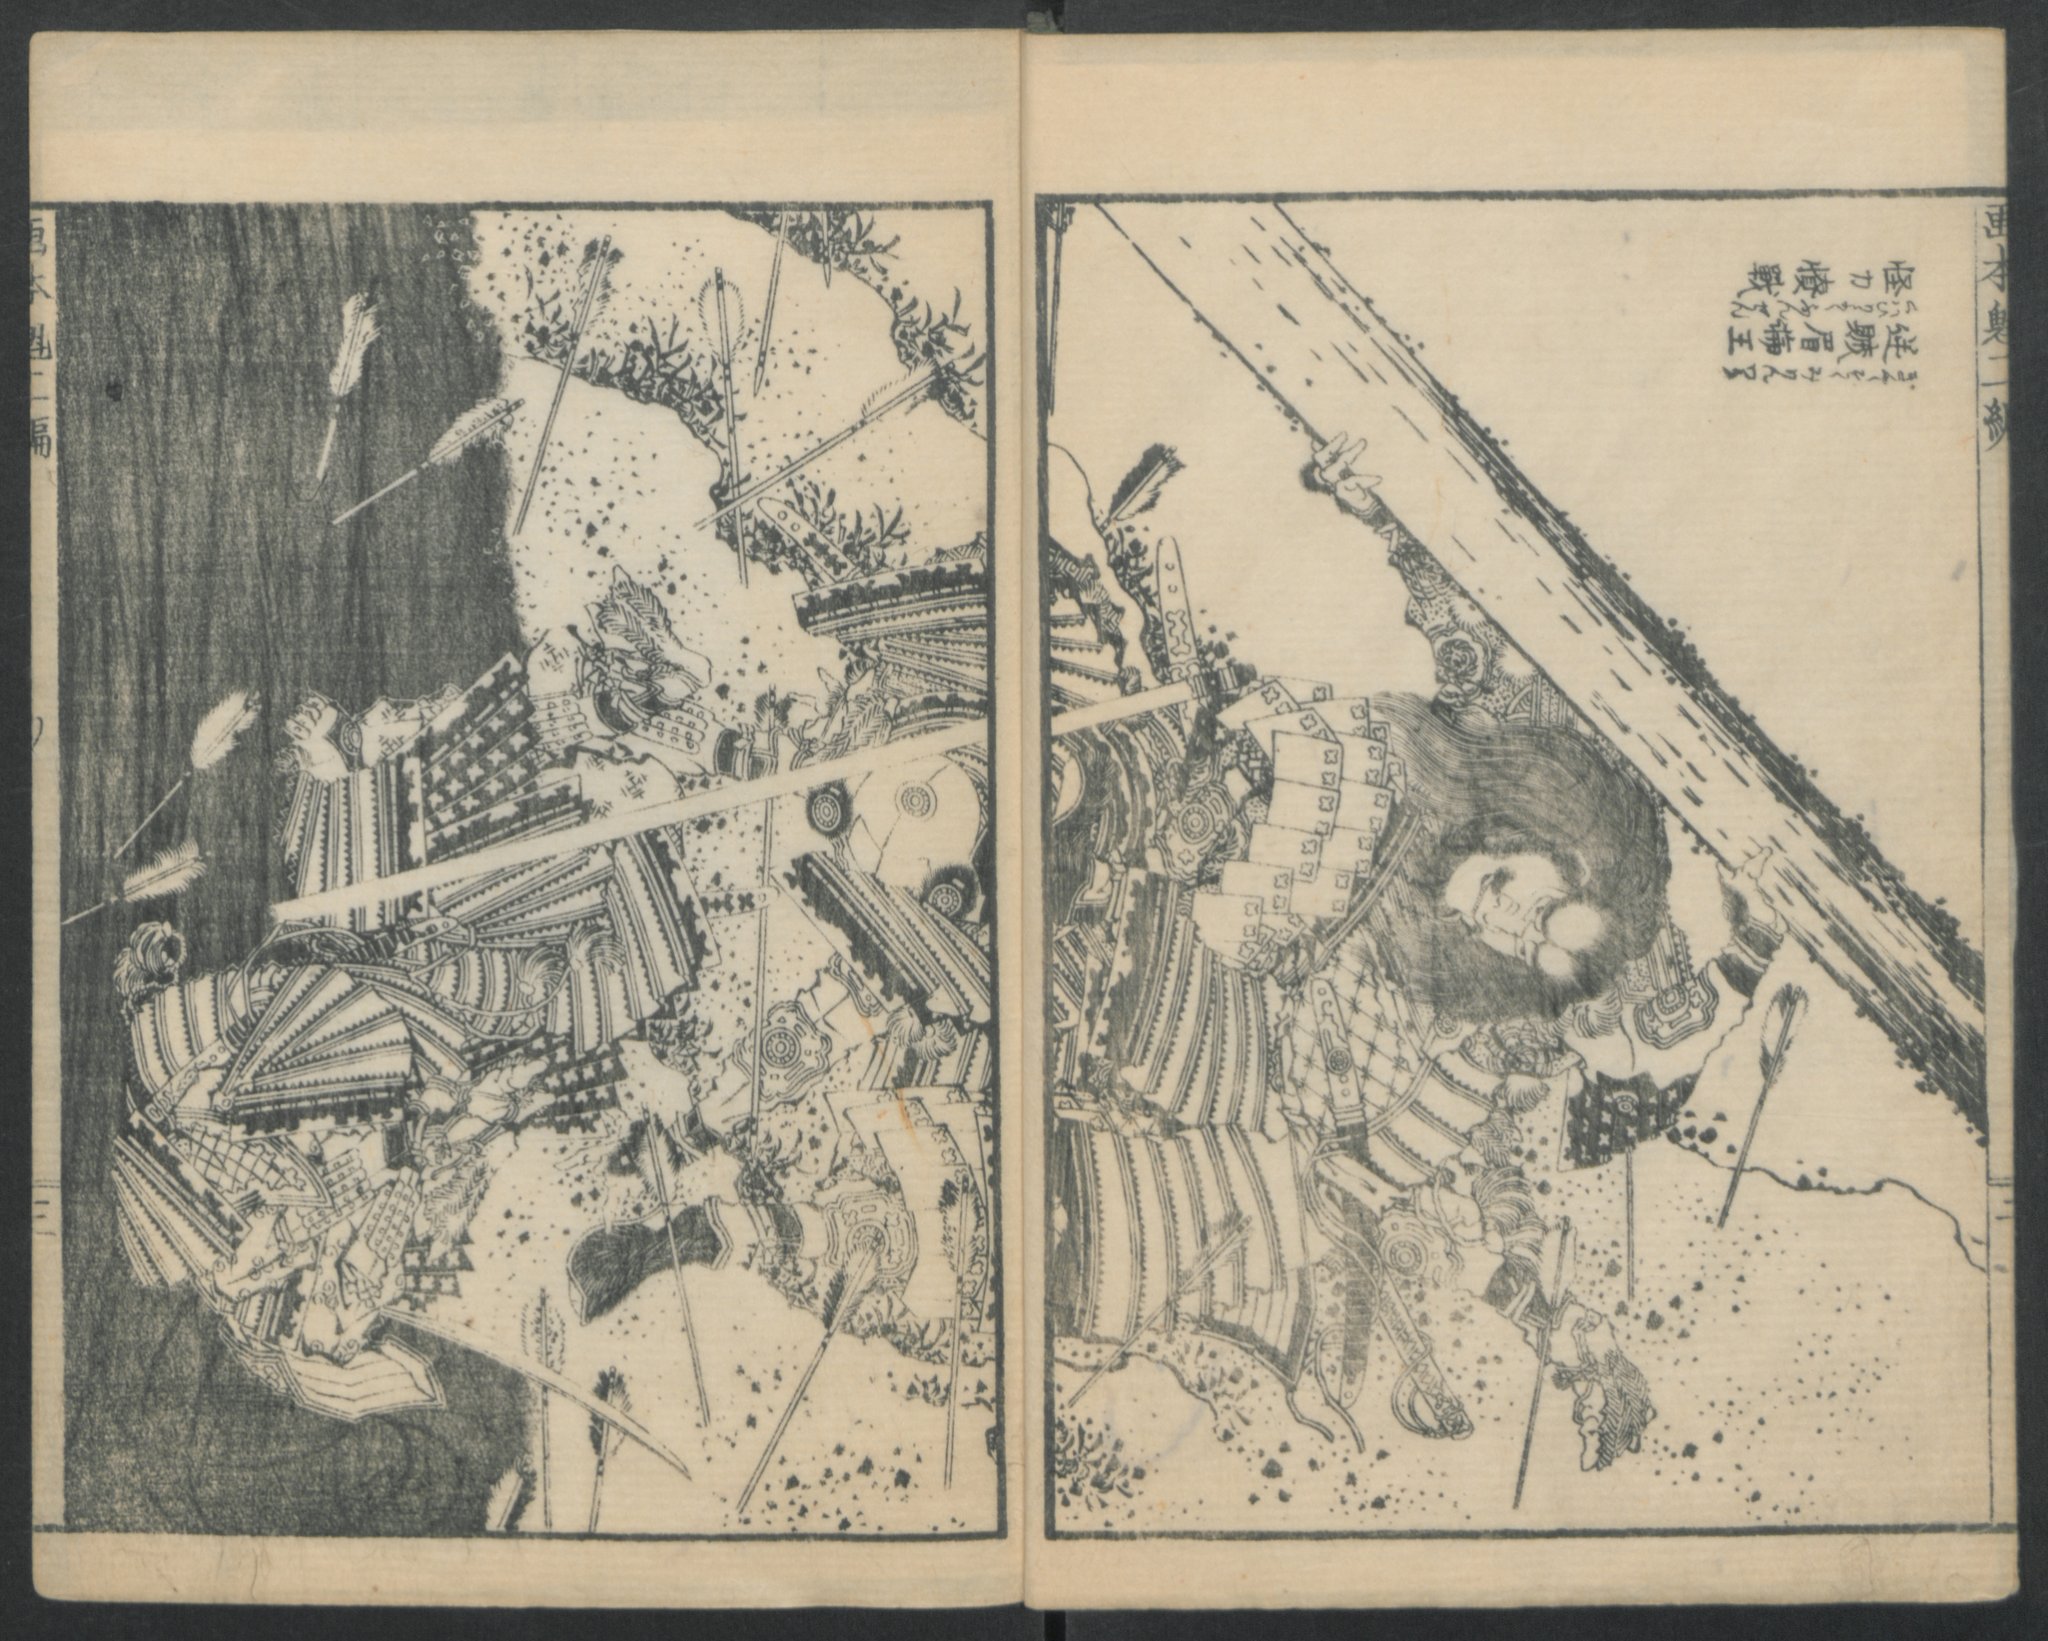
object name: illustrated book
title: A Picture Book of Japanese Warriors (Ehon Musashi Abumi) 絵本武蔵鐙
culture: japanese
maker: katsushika hokusai 葛飾北斎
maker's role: artist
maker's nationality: japanese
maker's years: 1760-1849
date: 1836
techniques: polychrome, woodblock print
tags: men,warriors